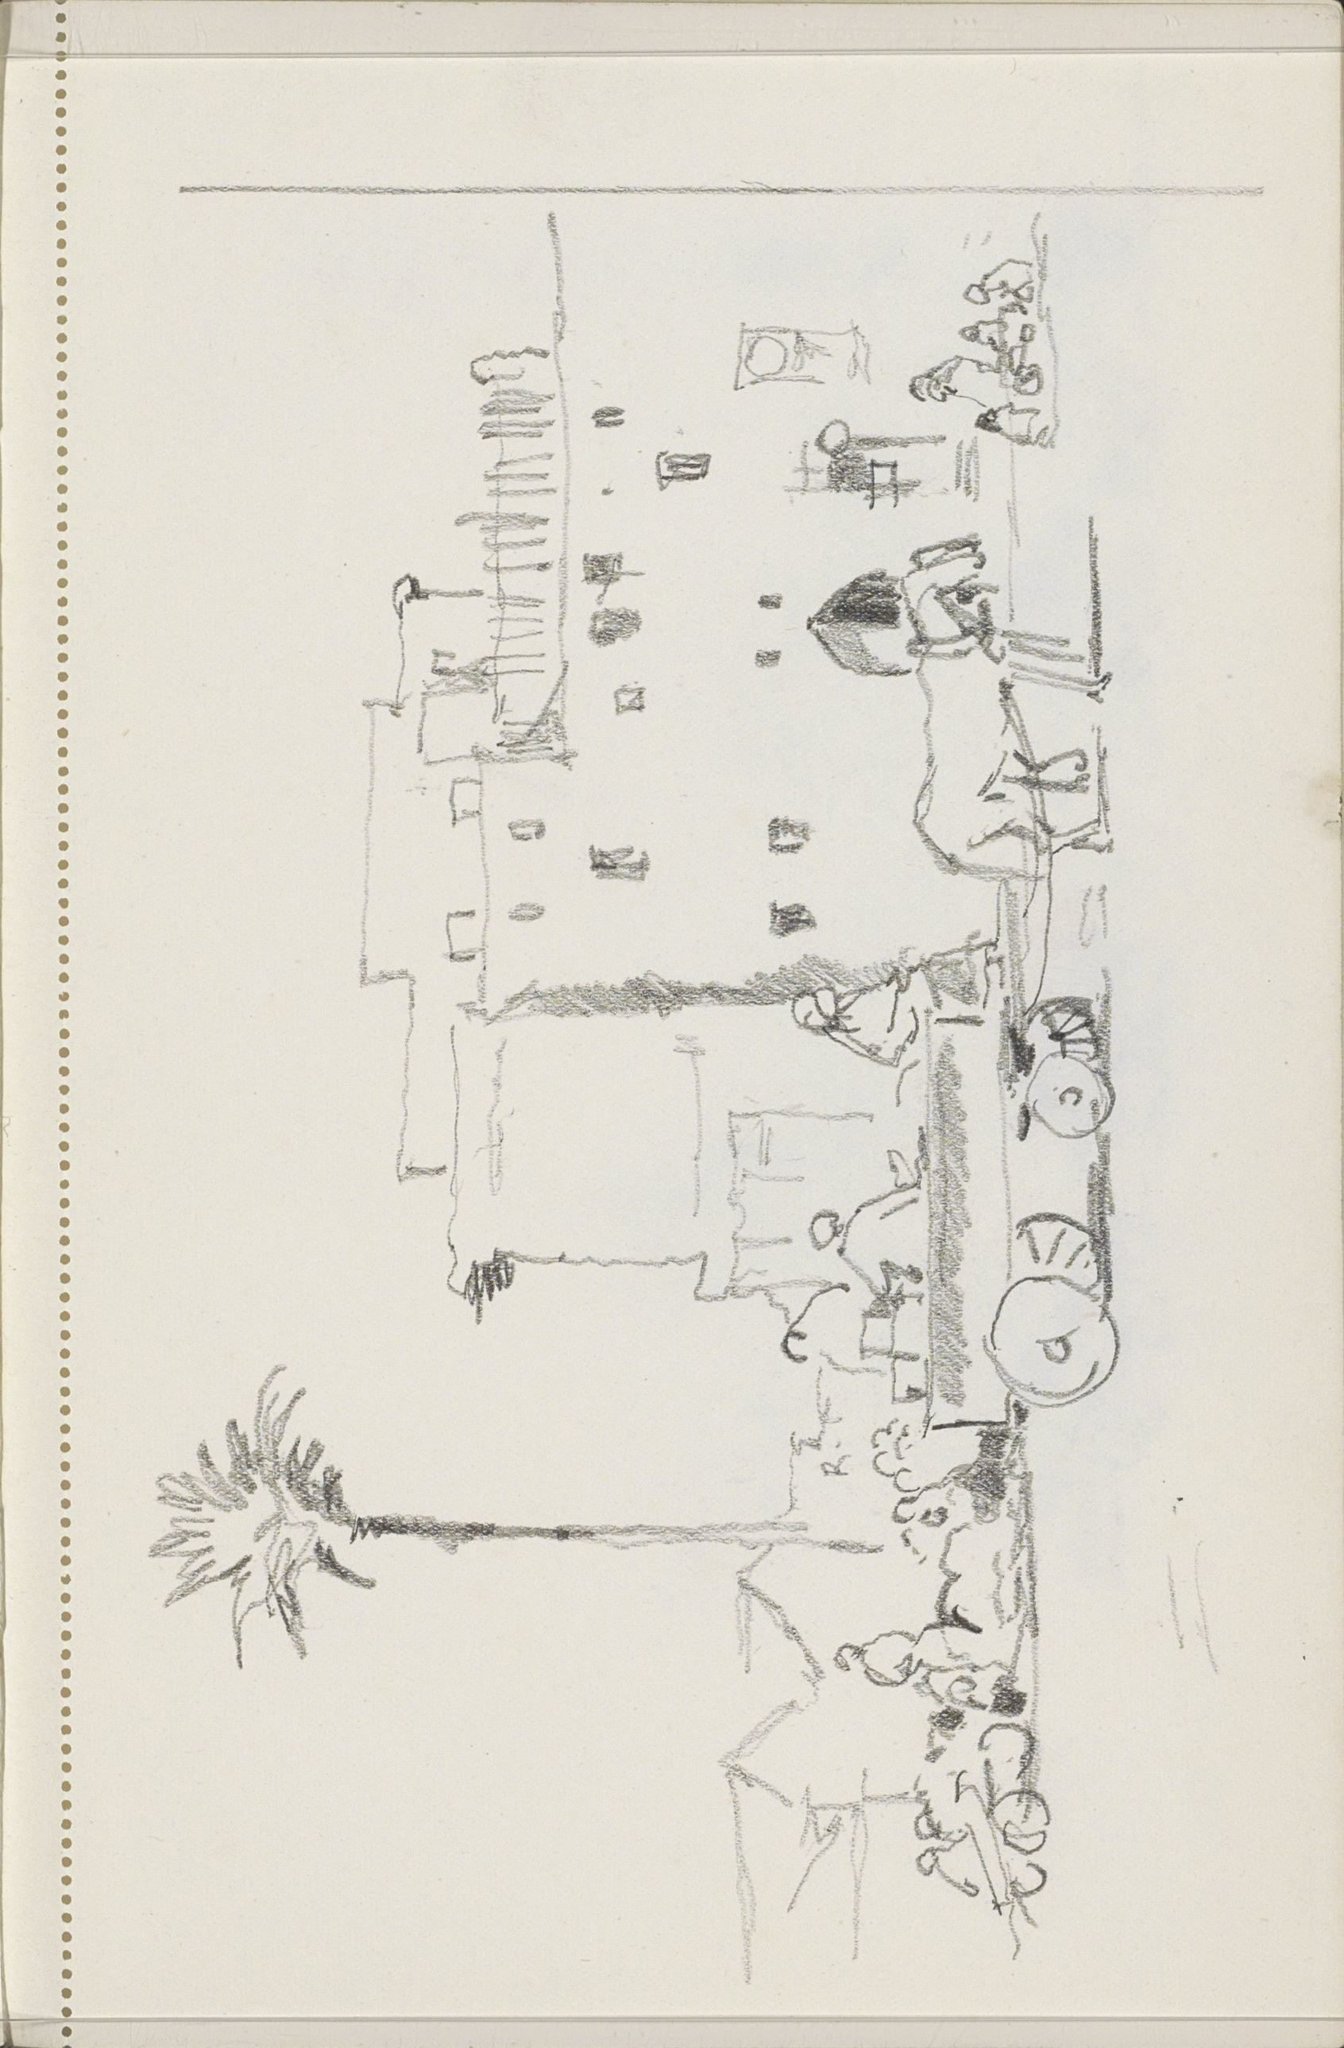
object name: sketchbook leaf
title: Straat in Noord-Afrika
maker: cornelis vreedenburgh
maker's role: draughtsman, print maker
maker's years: 1880-1946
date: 1936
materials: paper, pencil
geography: maghreb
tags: street (+ city(-scape) with figures, staffage)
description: Op de straat figuren, een paard en wagen en een palmboom. Blad 29 recto uit een schetsboek met 73 bladen.